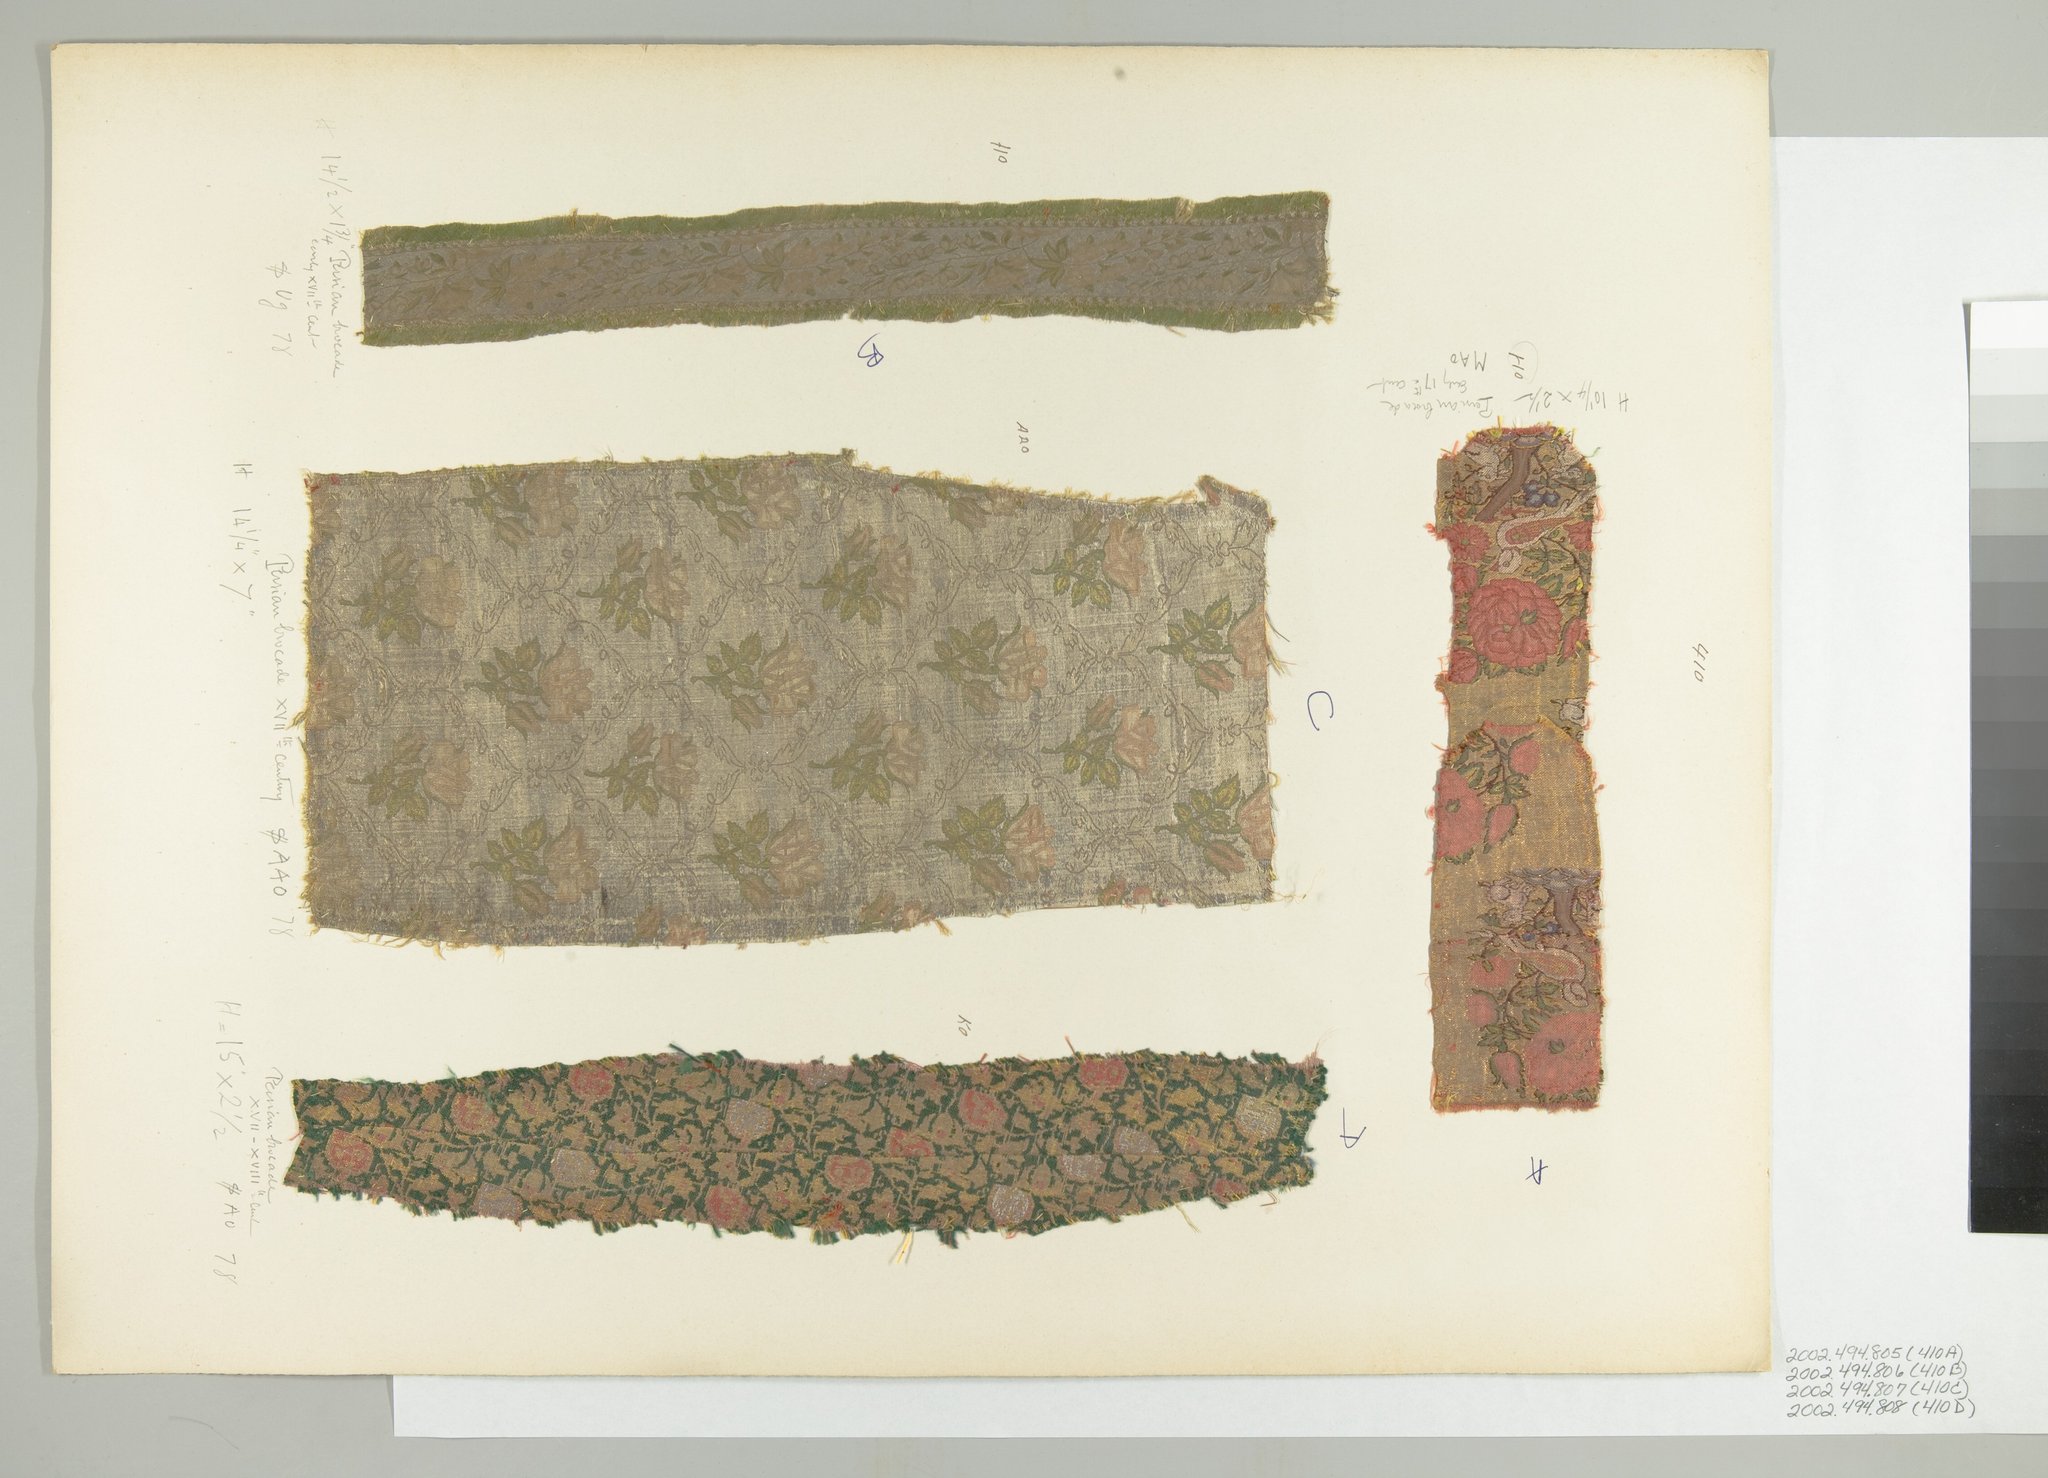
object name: textile fragment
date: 1601-1700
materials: metal thread, silk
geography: iran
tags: flowers